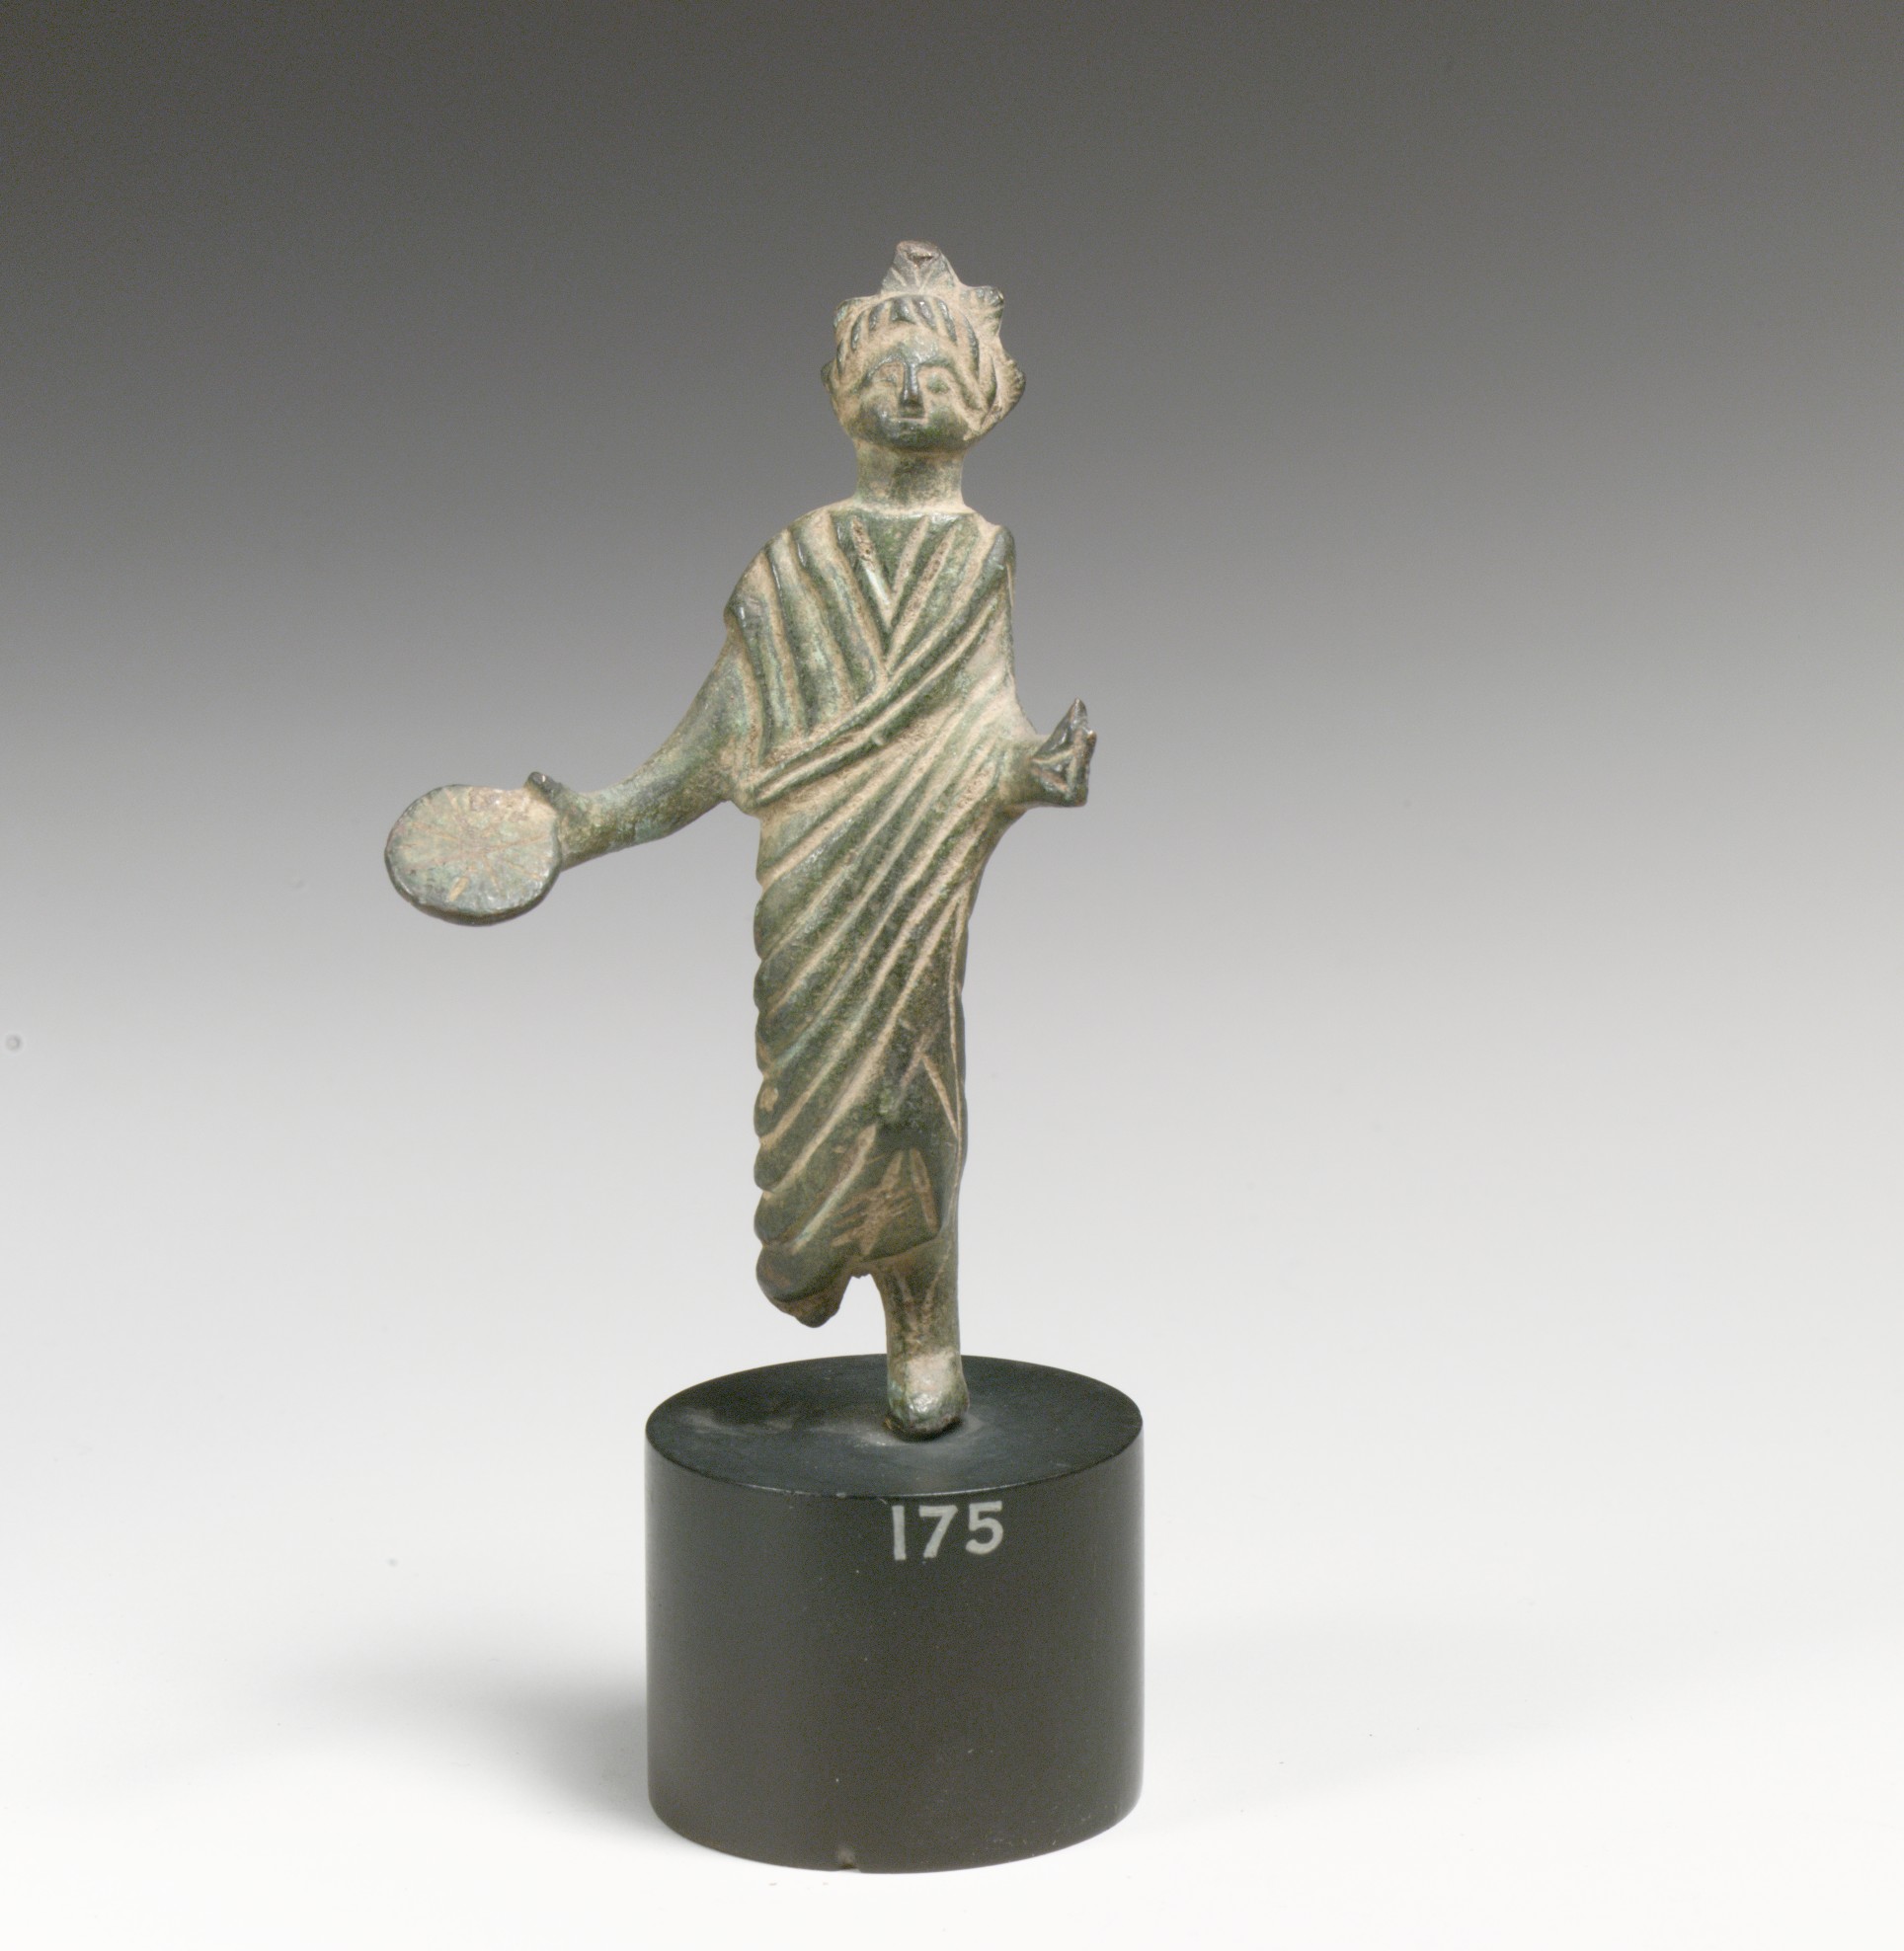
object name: statuette of a man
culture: etruscan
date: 300-1 BCE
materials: bronze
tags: men